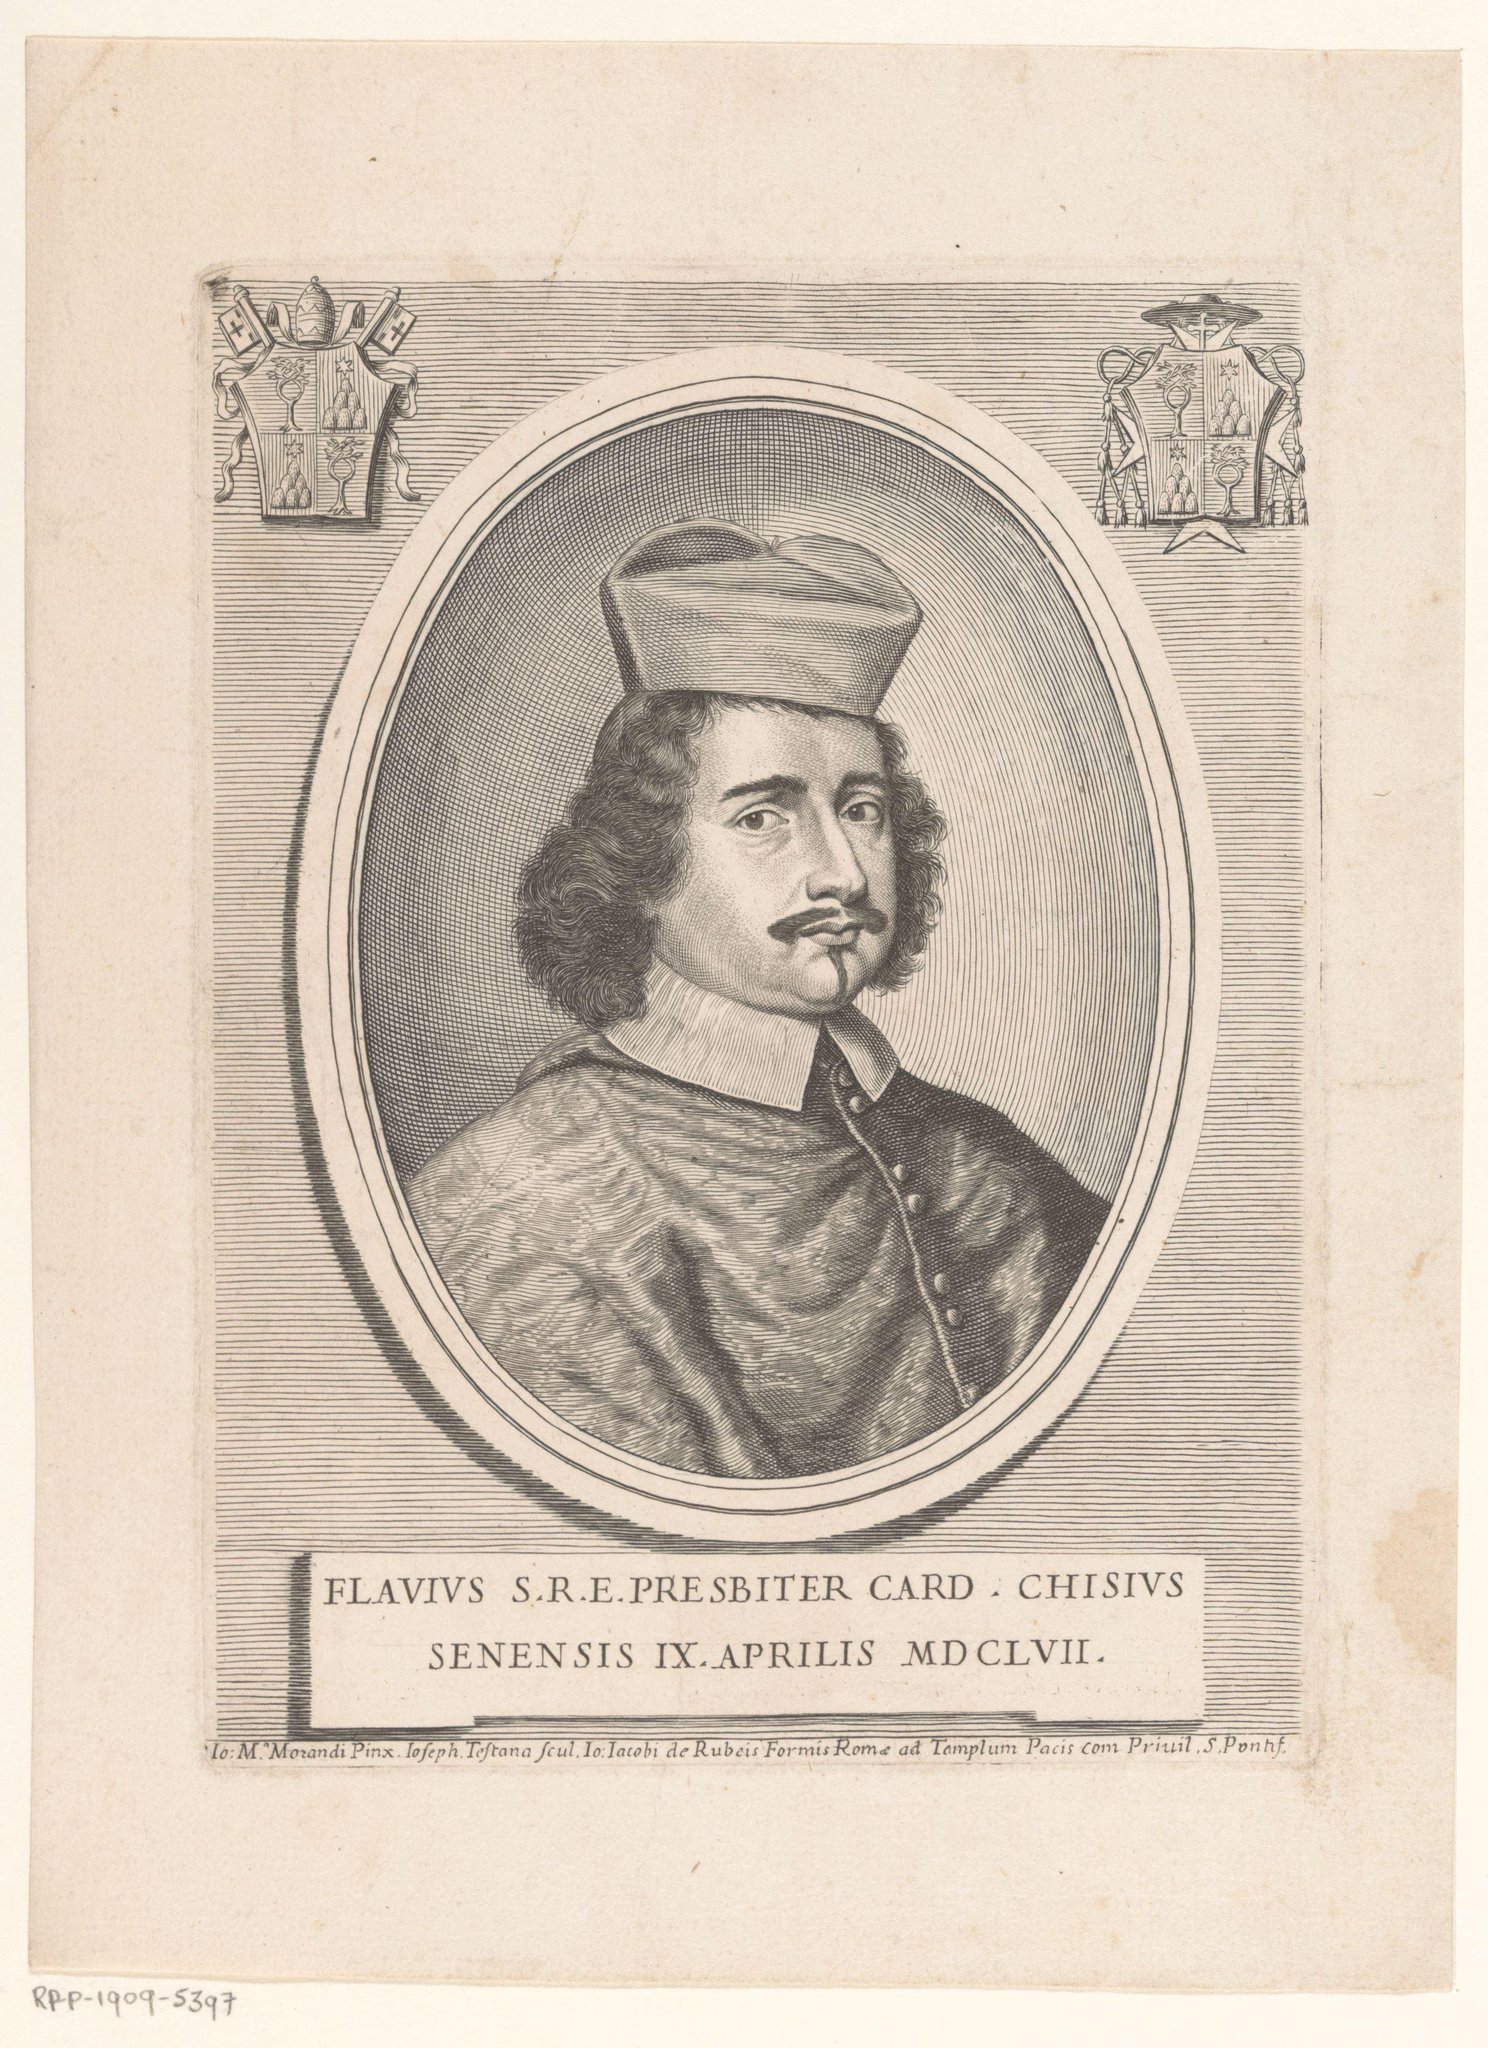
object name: print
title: Portret van kardinaal Flavio Chigi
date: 1658-1679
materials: paper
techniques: engraving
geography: rome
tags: rome, flavio chigi, cardinal, historical persons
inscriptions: collector's mark: Lugt 2228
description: Prent uit een reeks van onbekende omvang met portretten van kardinalen. De prenten werden vanaf 1657 vervaardigd in opdracht van uitgever Giovanni Giacomo de’ Rossi, waarna de productie werd voortgezet onder leiding van zijn opvolgers Domenico de’ Rossi en Lorenzo Filippo de’ Rossi, en ten slotte onder leiding van de Calcographia R.C.A.